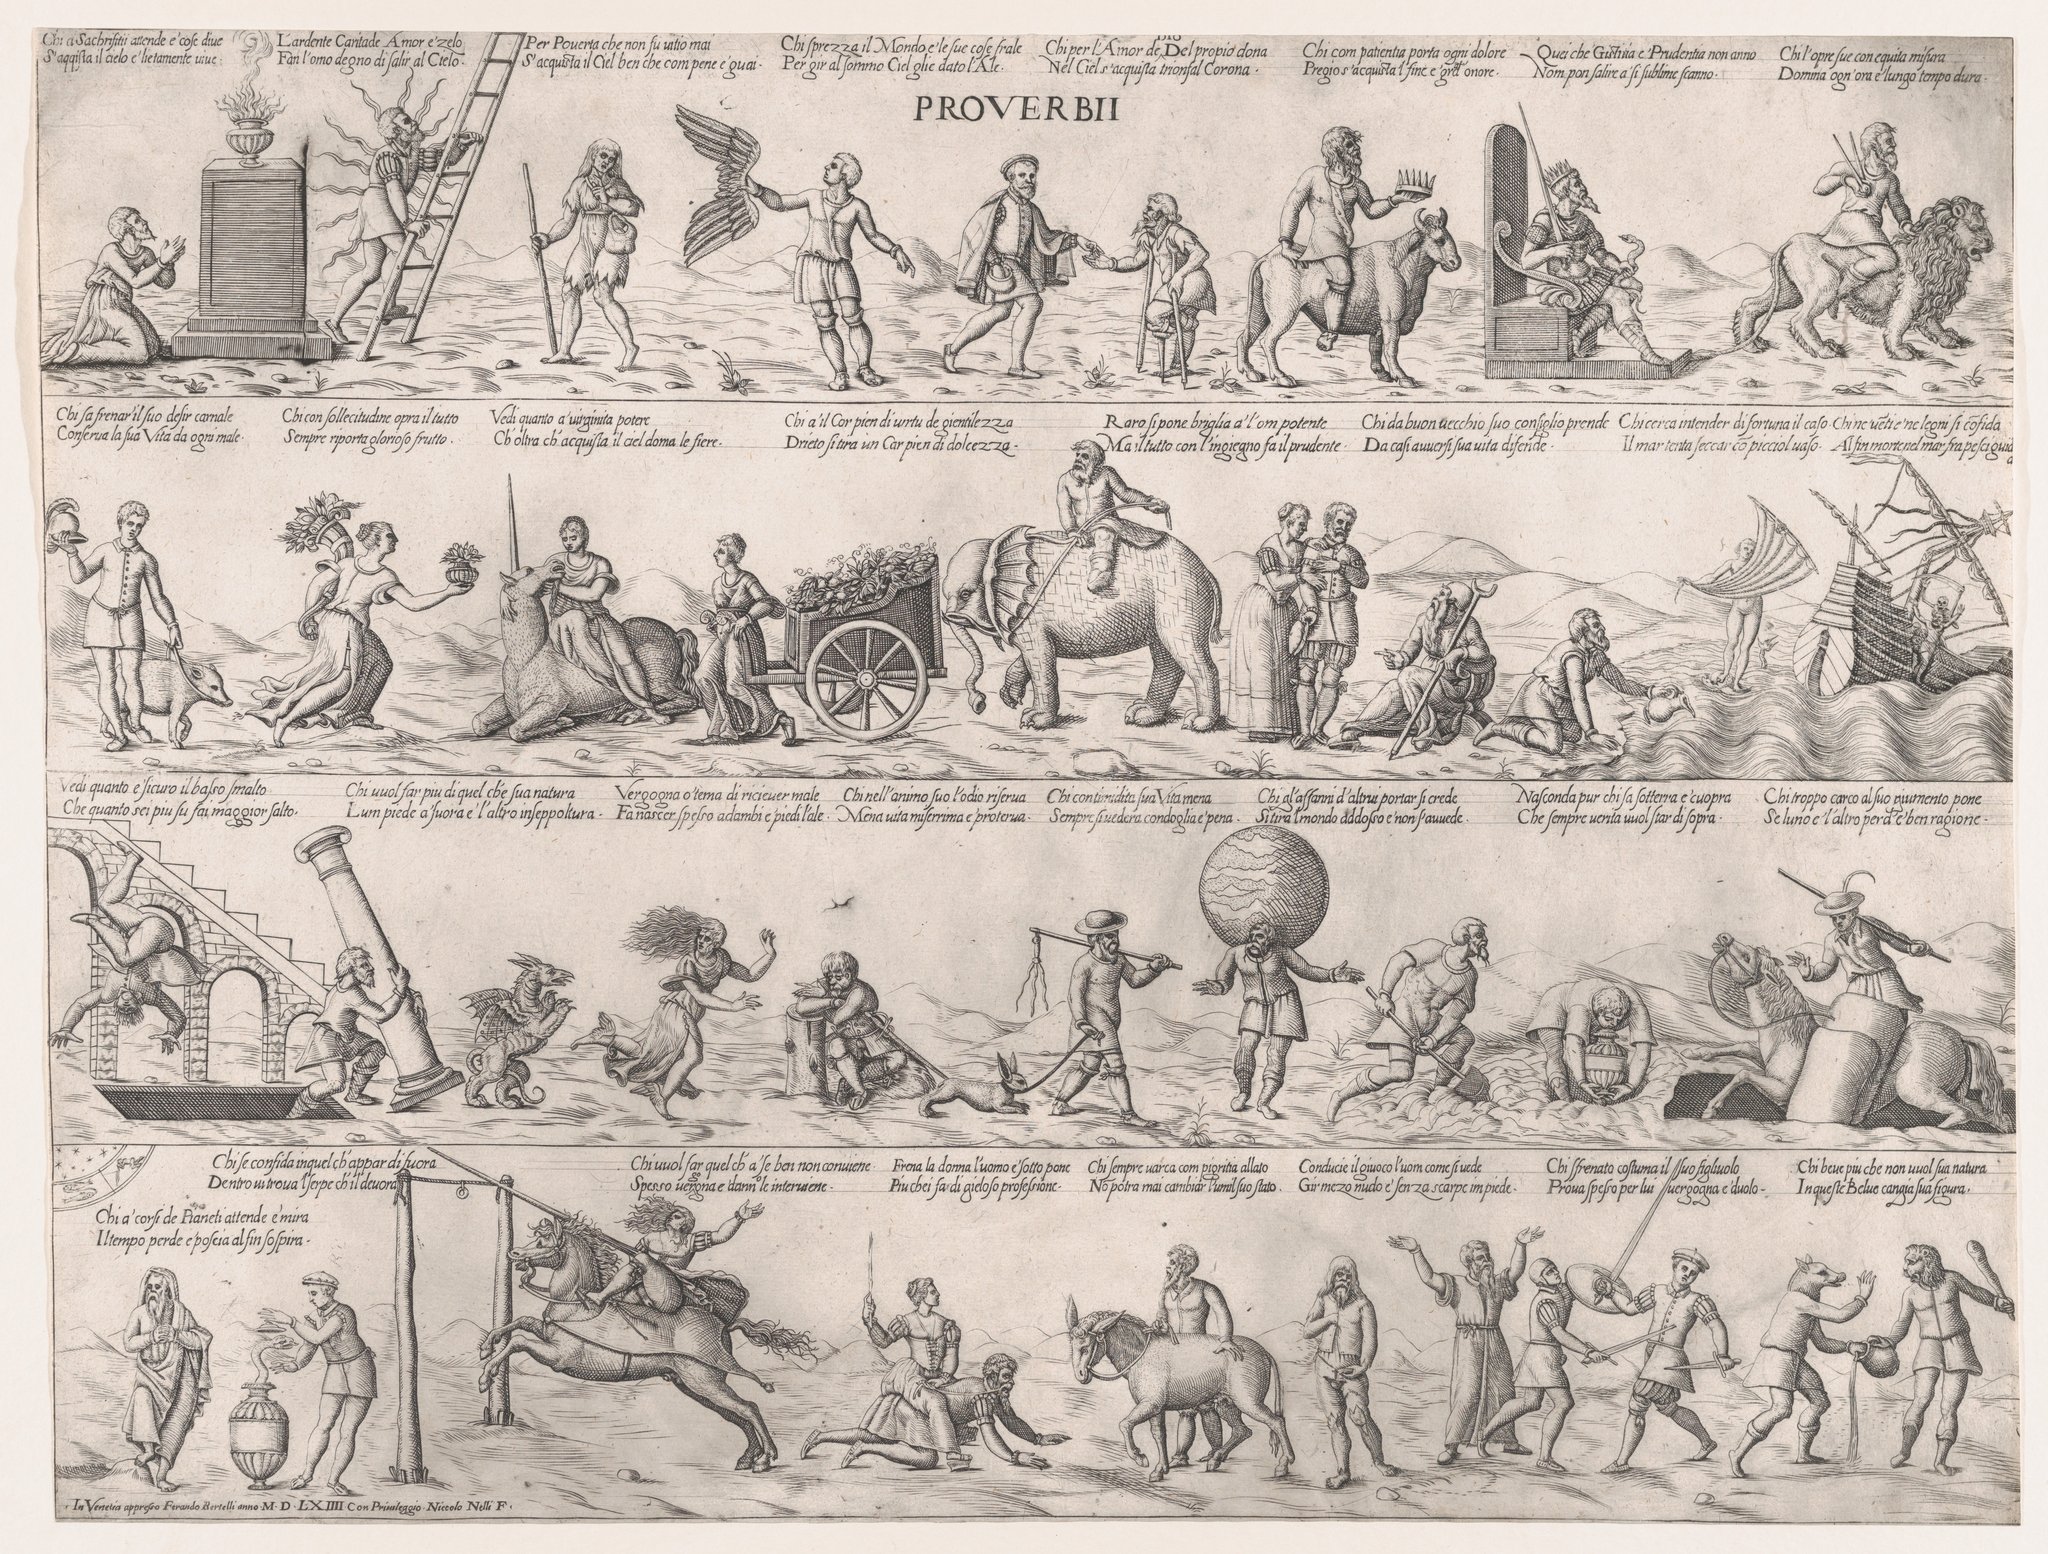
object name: print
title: Proverbi (Proverbs)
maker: nicolò nelli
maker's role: artist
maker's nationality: italian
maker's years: 1552-1579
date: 1564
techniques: engraving, etching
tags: men,women,elephants,horses,lions